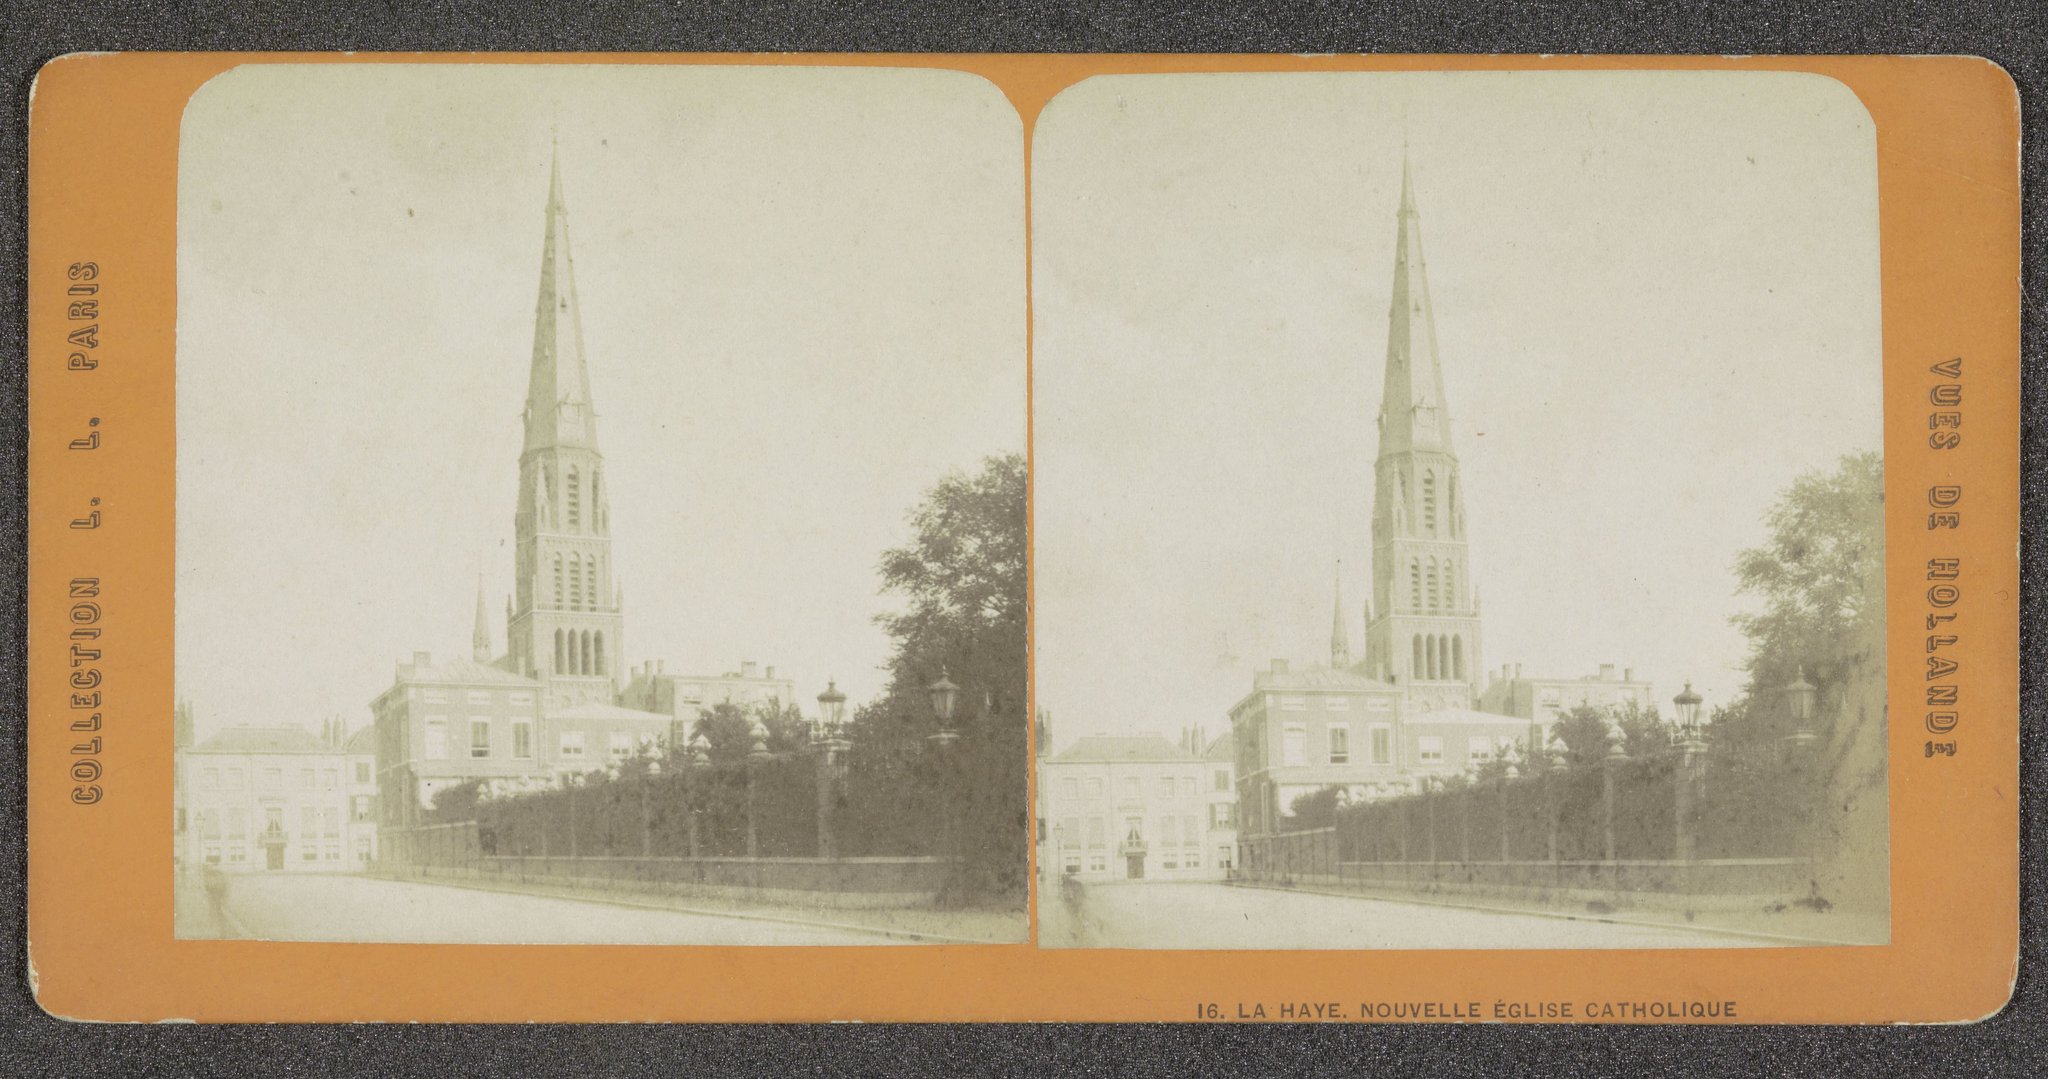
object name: stereograph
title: La Haye. Nouvelle Eglise Catholique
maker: Anonymous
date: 1878-1890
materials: cardboard, paper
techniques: albumen print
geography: paris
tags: parts of church exterior and annexes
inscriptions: number: ‘16.’